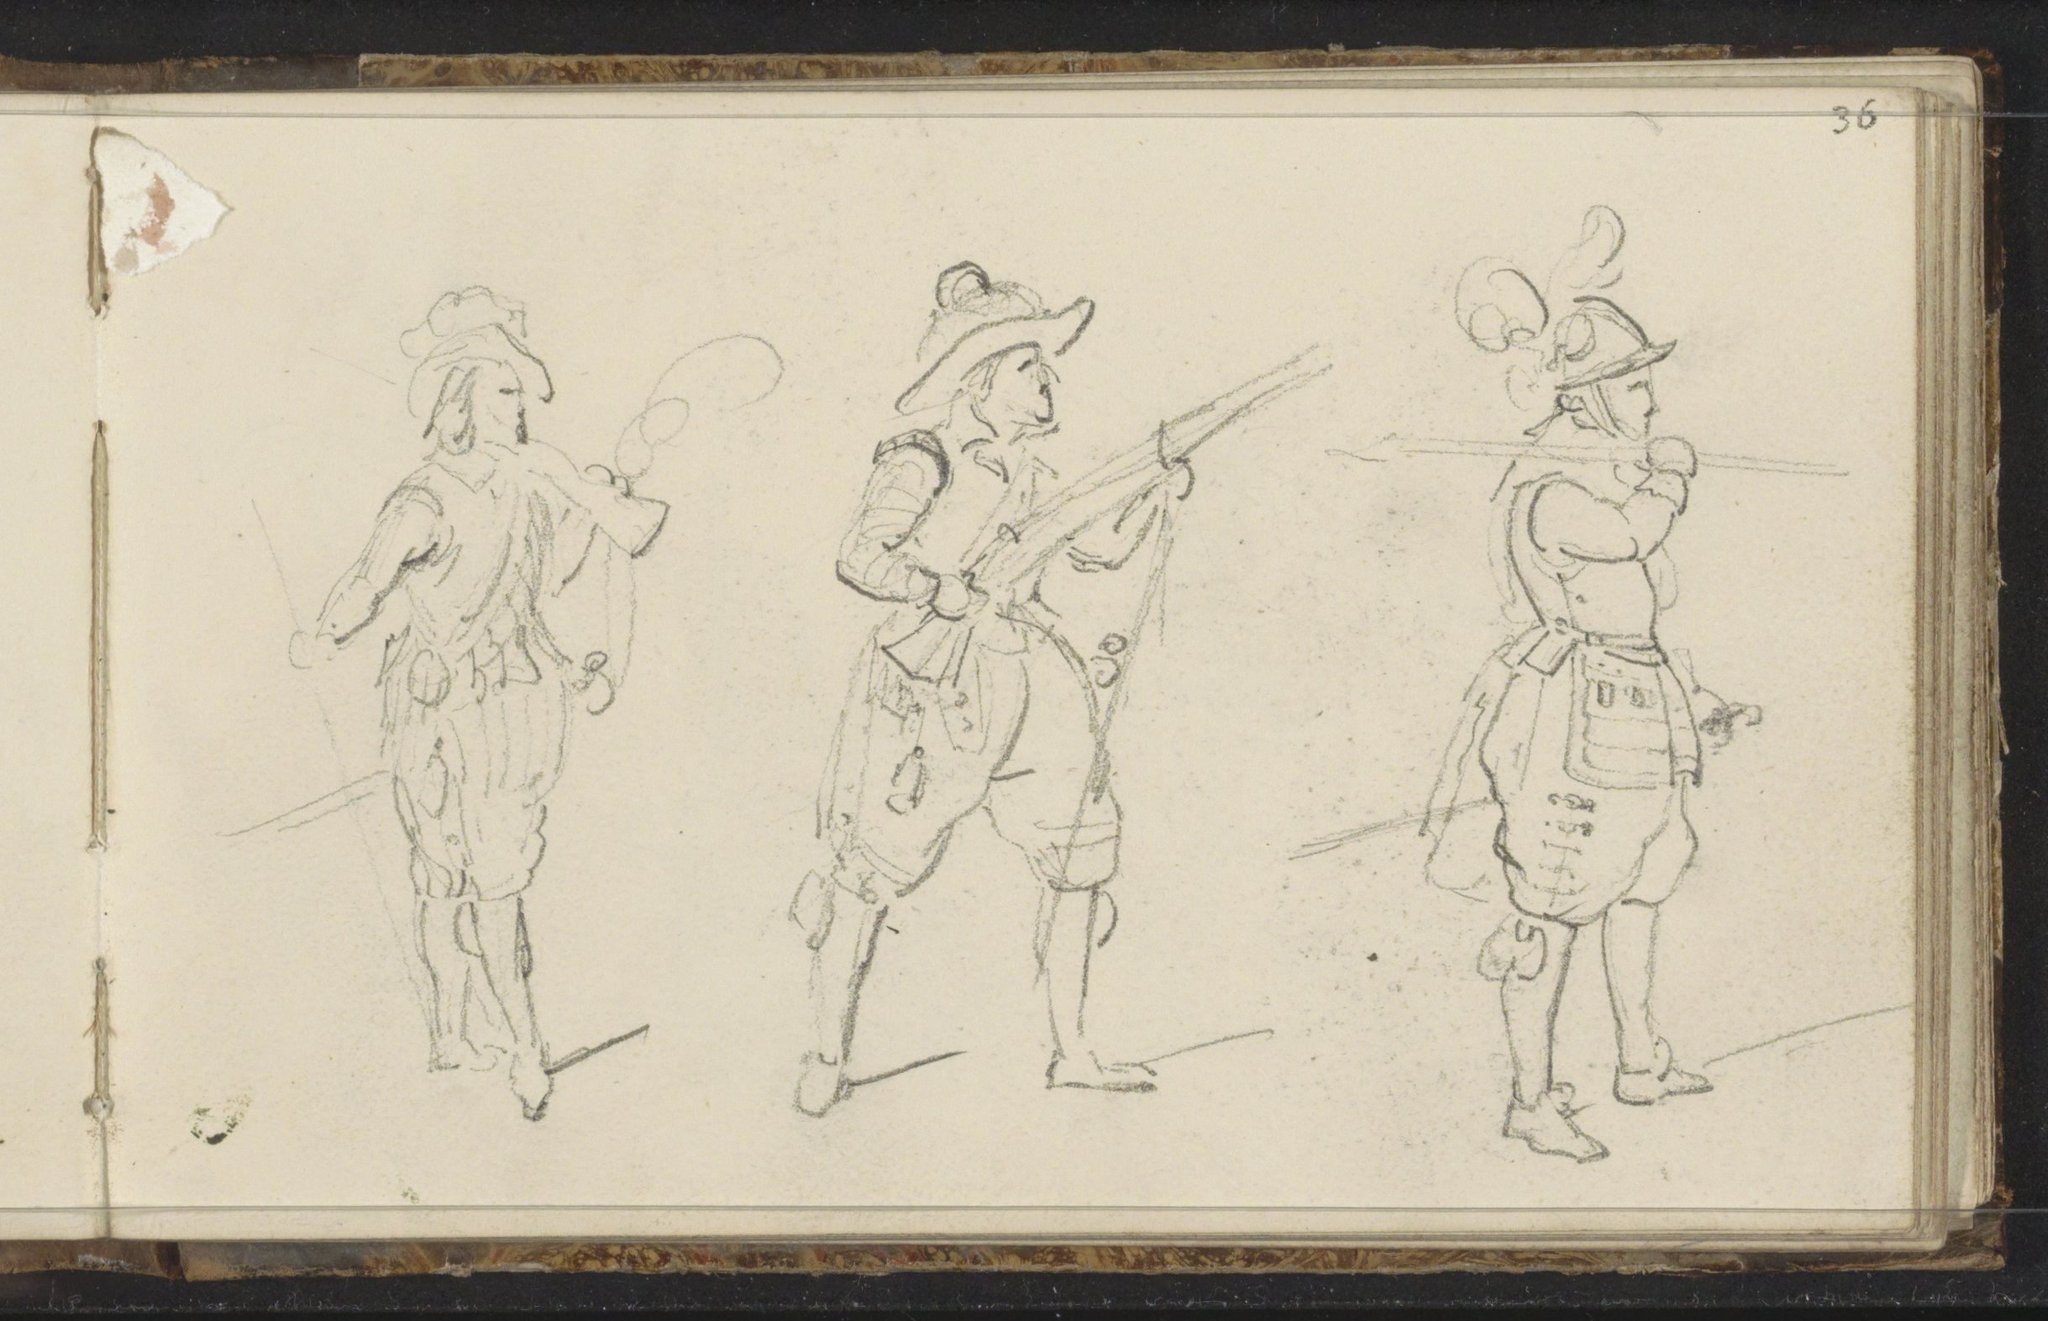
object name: sketchbook leaf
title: Soldaat met een geweer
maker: willem hendrik schmidt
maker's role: draughtsman, painter, print maker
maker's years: 1809-1849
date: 1819-1849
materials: paper, pencil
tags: the soldier; the soldier's life, firearms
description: Blad 36 recto uit een schetsboek met 60 bladen.